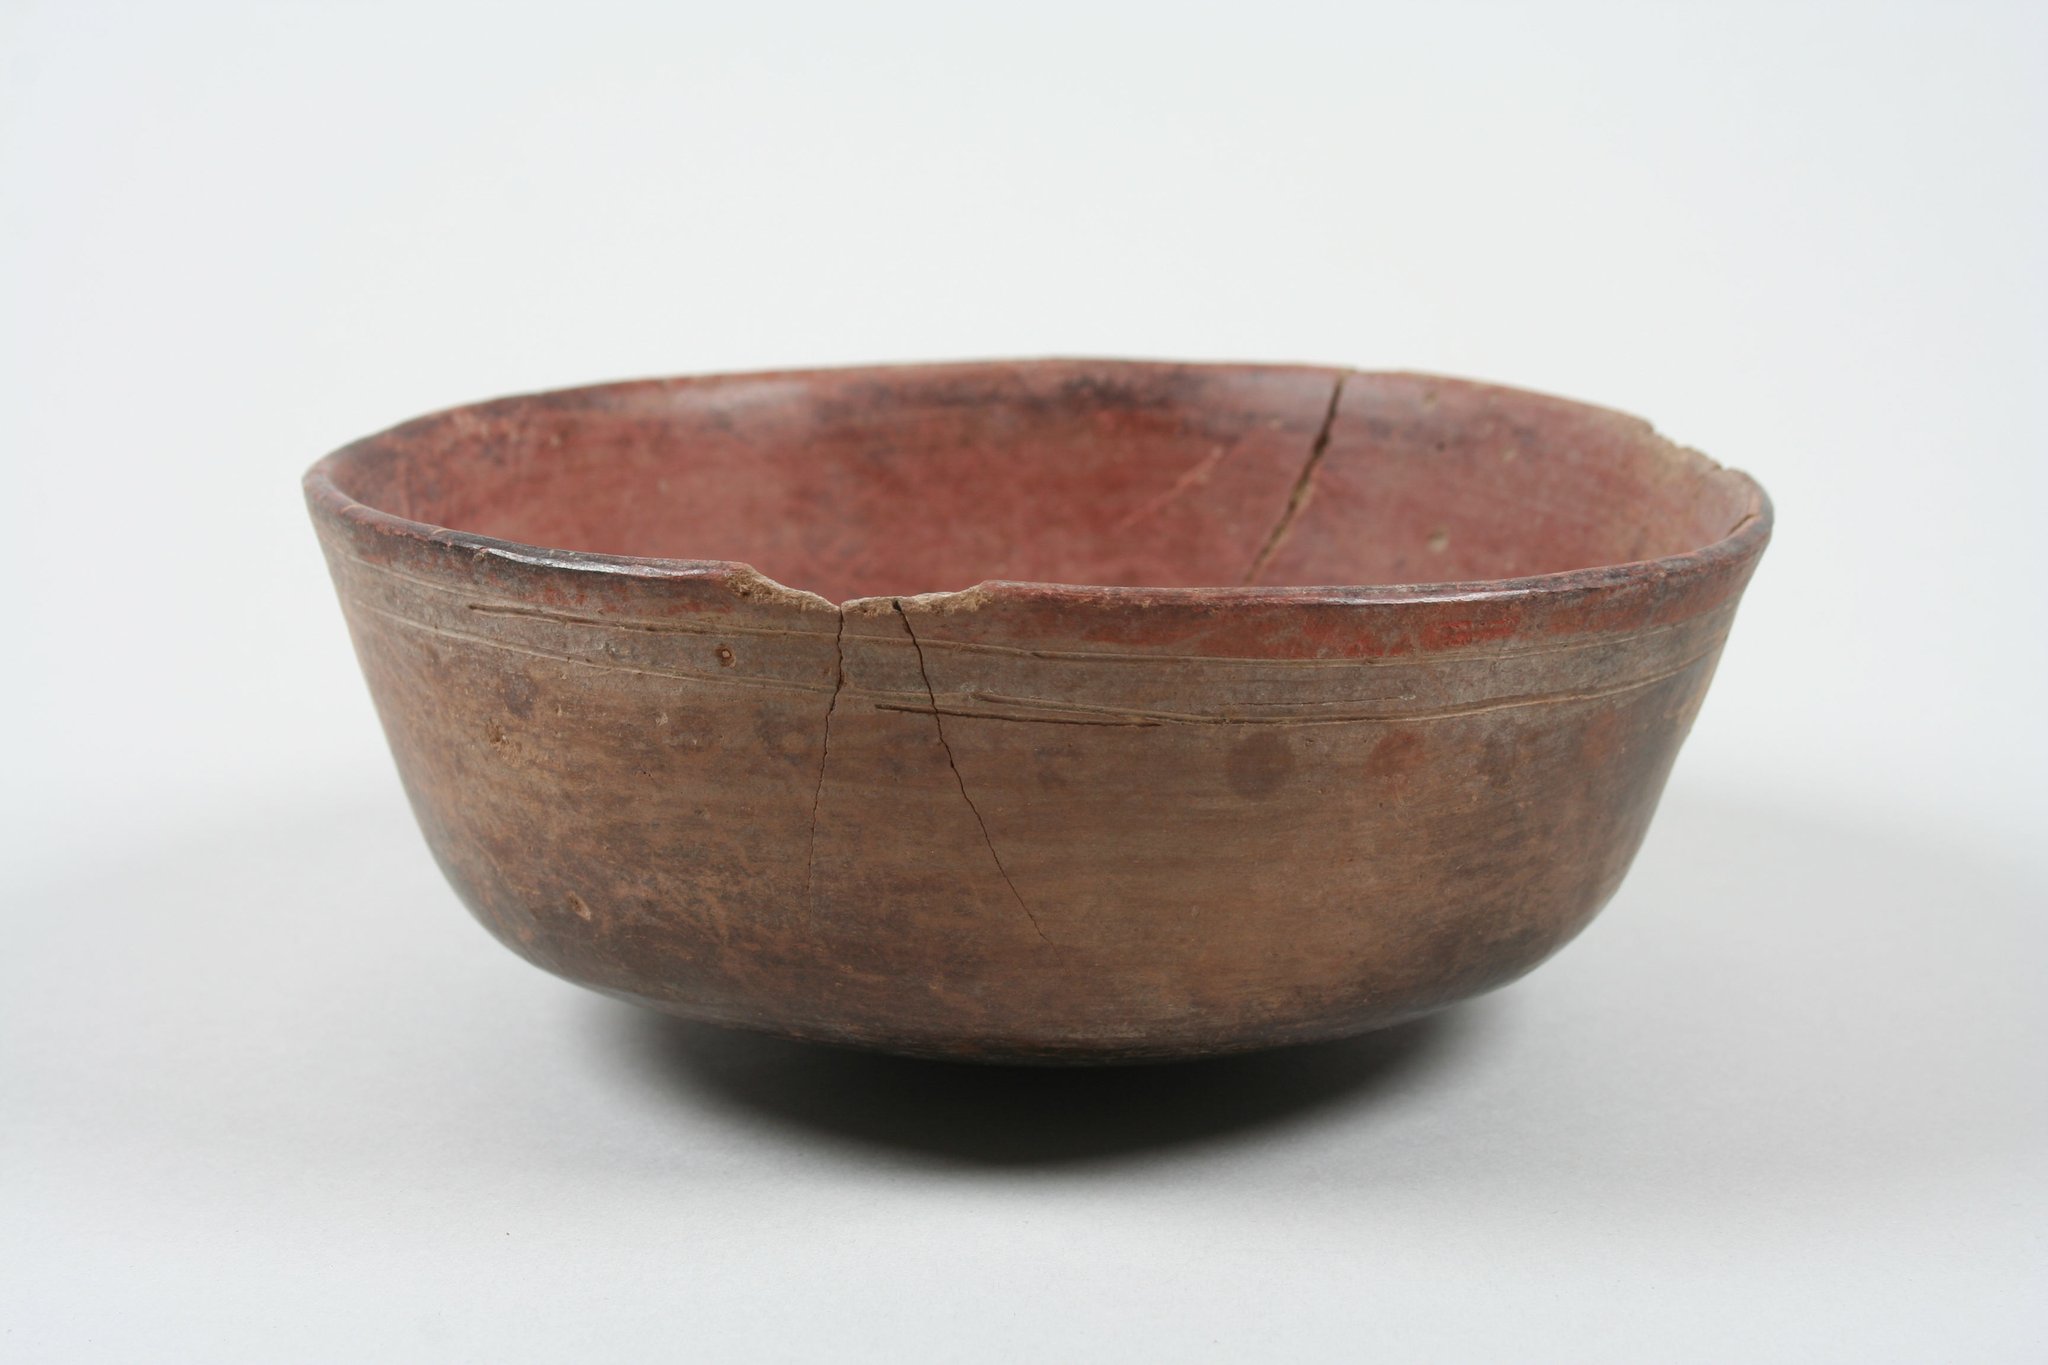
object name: bowl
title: Incised bowl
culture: paracas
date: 600-301 BCE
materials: ceramic, pigment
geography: peru